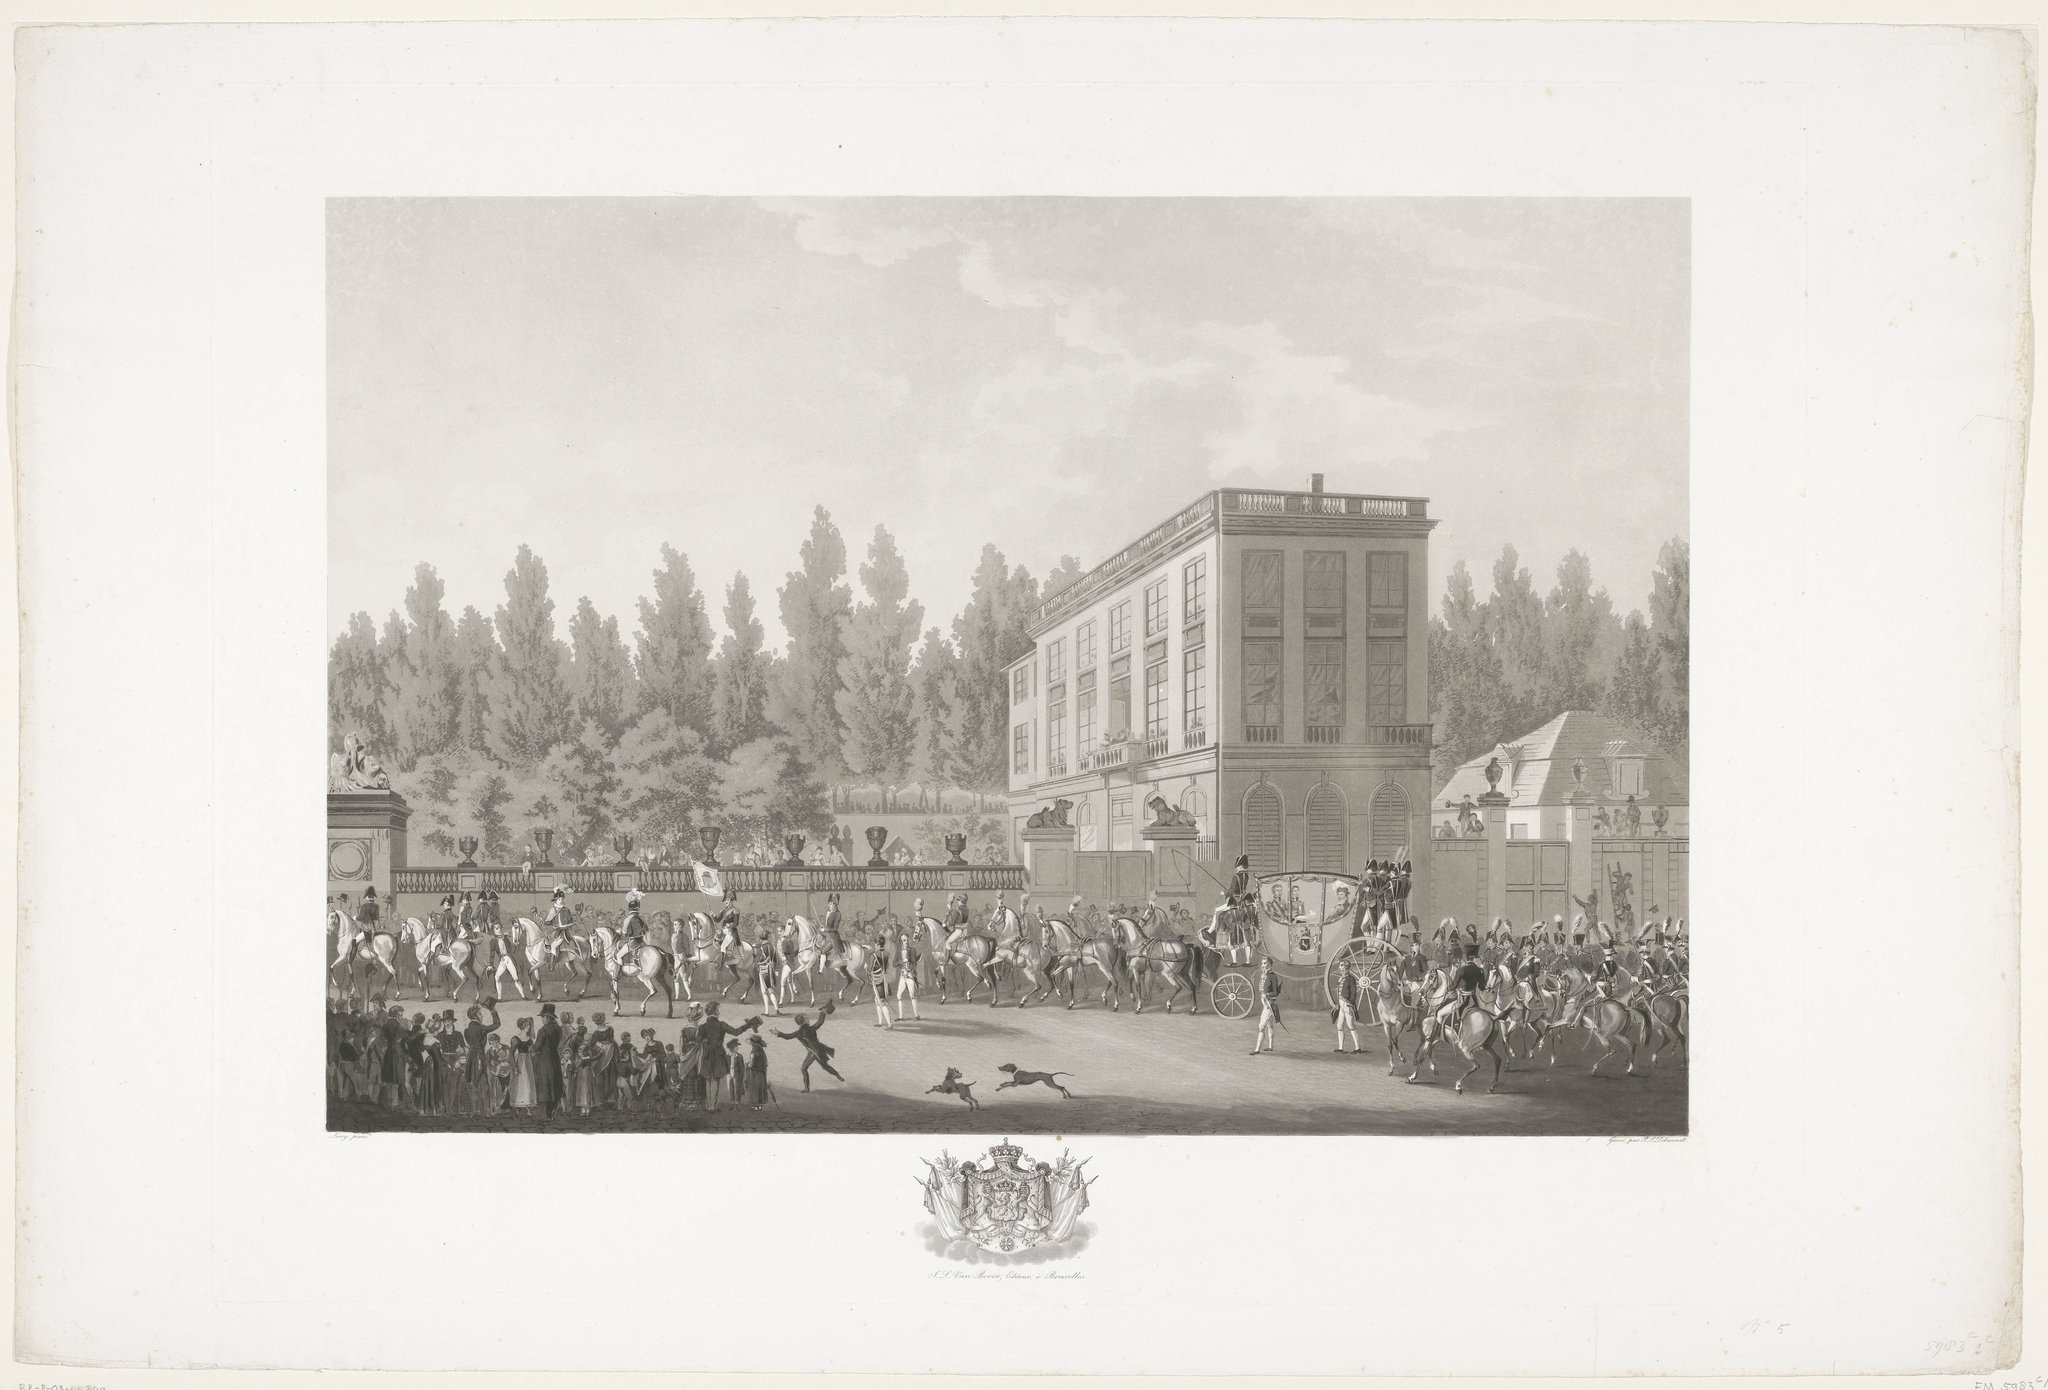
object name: history print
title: Twaalf platen van de aankomst en inhuldiging van Willem I in Brussel en de slagen bij Quatre-Bras en Waterloo in 1815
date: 1825-1826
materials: paper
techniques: aquatint, etching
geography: brussels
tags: berlin, william i of the netherlands, triumphal entry and public reception, pageant, 'entrée solennelle', 'joyeuse entrée', homage to a ruler, brussels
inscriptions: collector's mark: Lugt 12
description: Plechtige intrede van de stoet voor de inhuldiging van koning Willem I te Brussel op 21 september 1815. Aankomst van de hofkoets met koning Willem I, getrokken door acht paarden. Onderaan het wapen van koning Willem I. Onderdeel van een serie platen van de aankomst en inhuldiging van Willem I in Brussel.